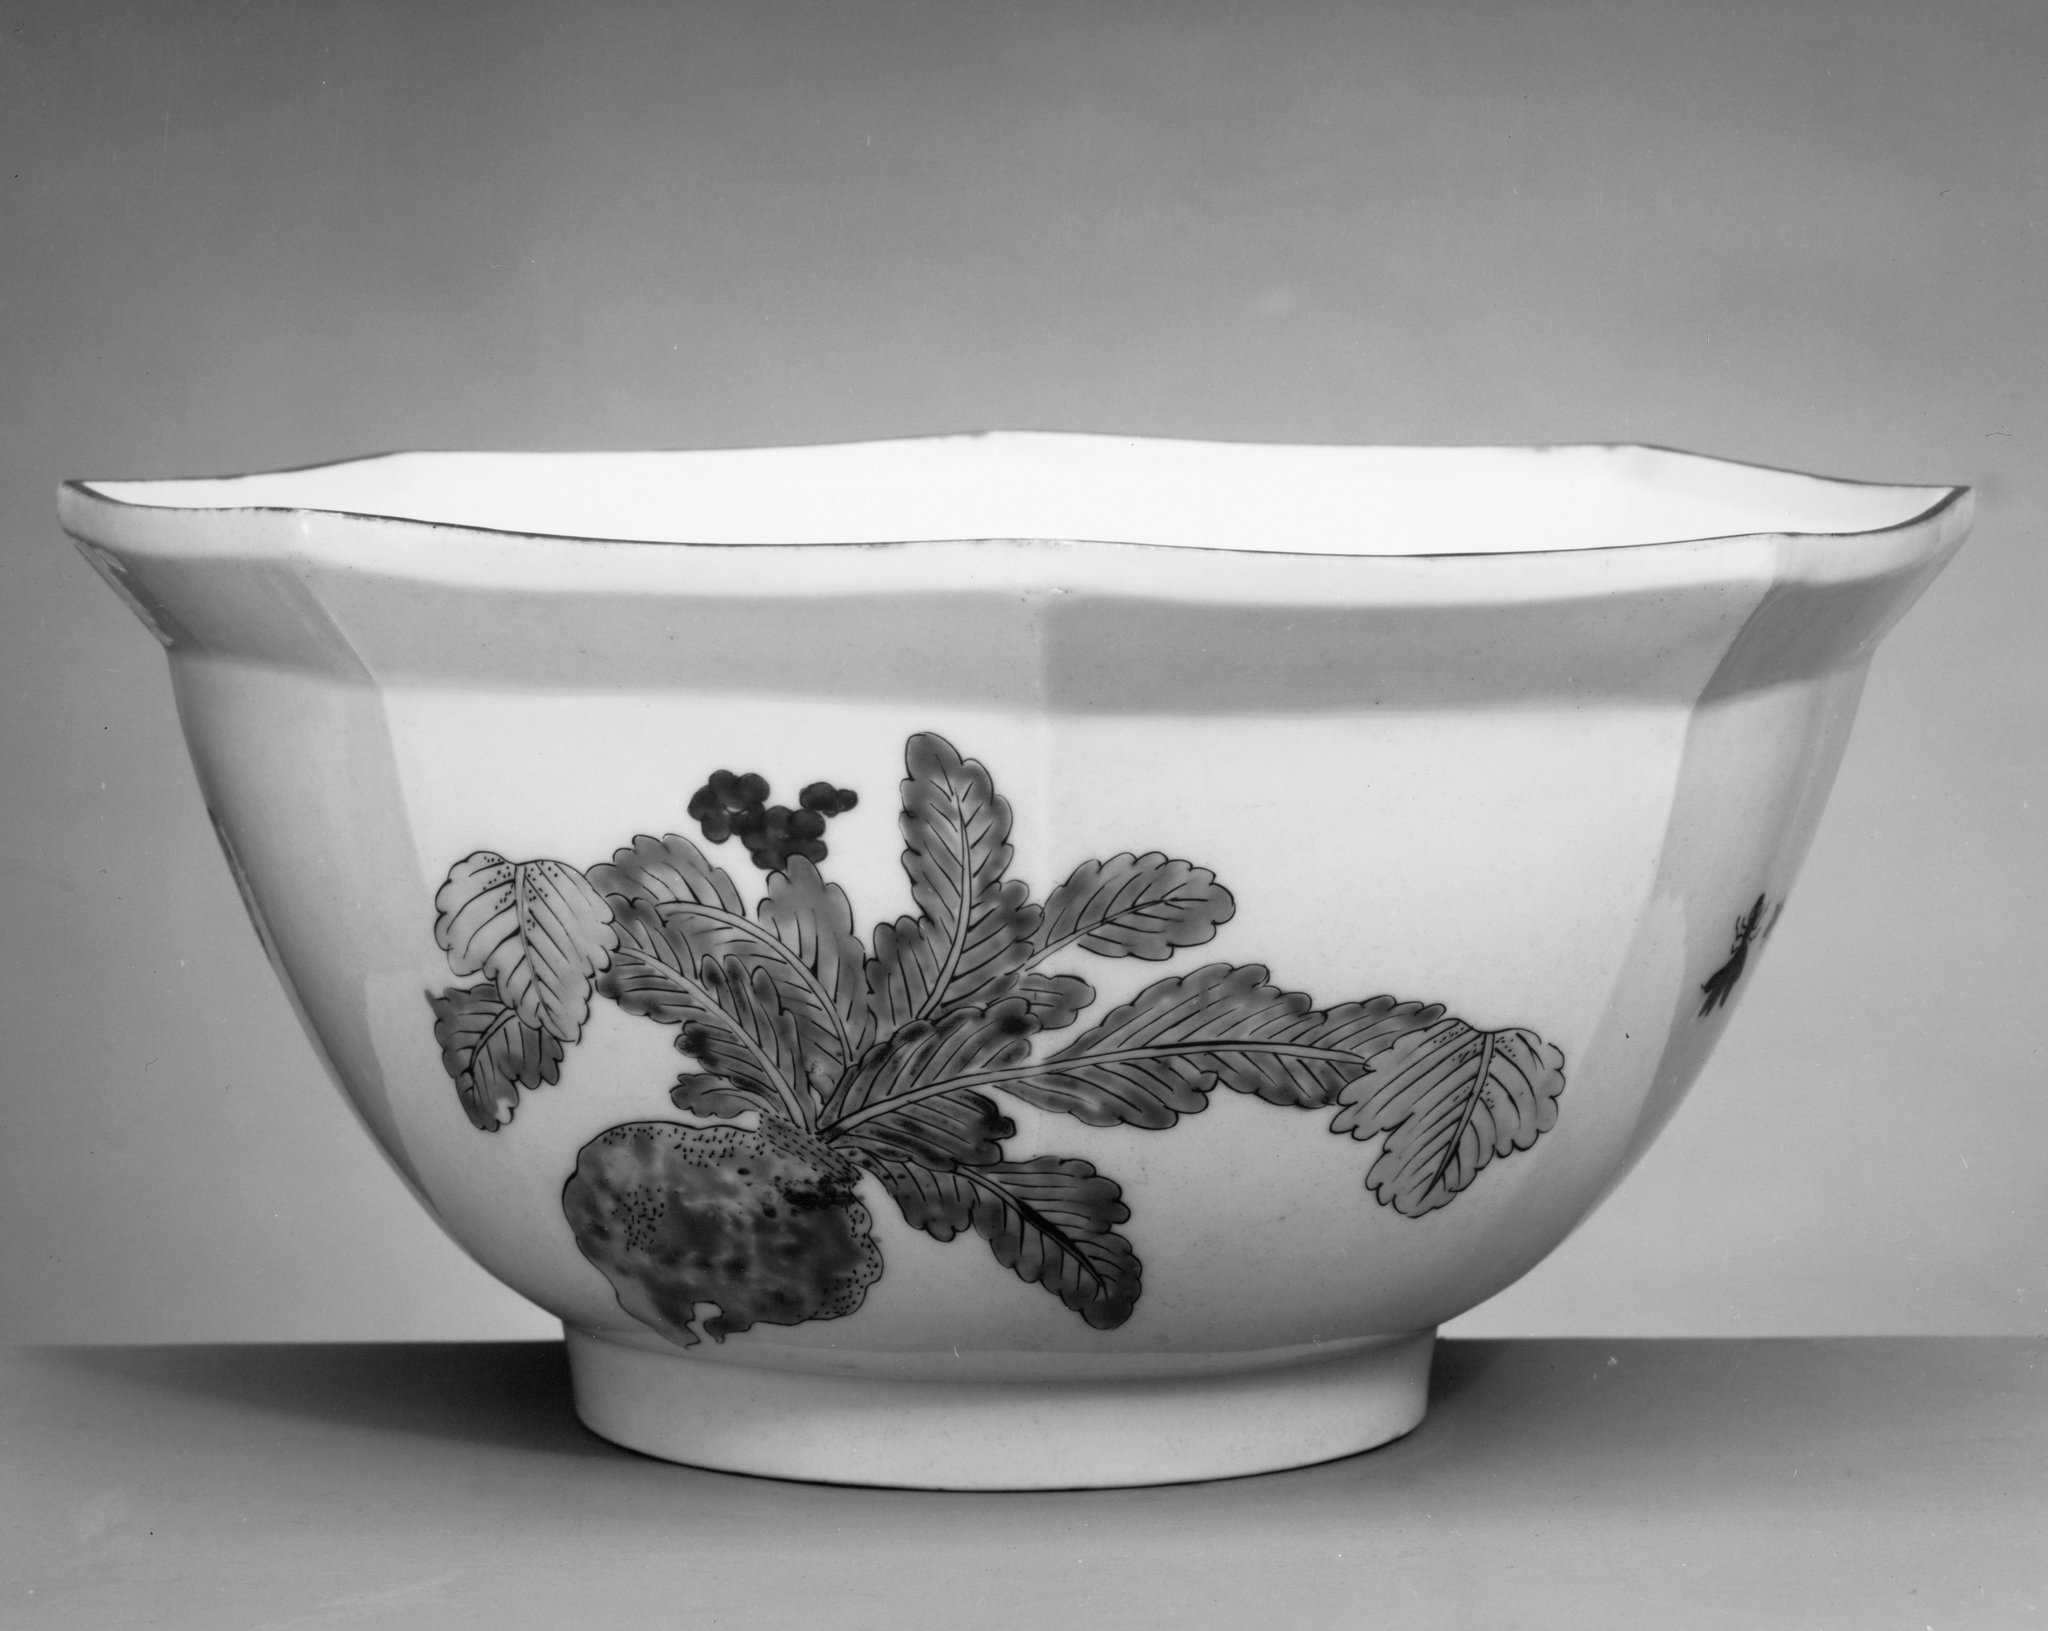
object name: octagonal bowl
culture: japanese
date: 1800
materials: enamel, porcelain